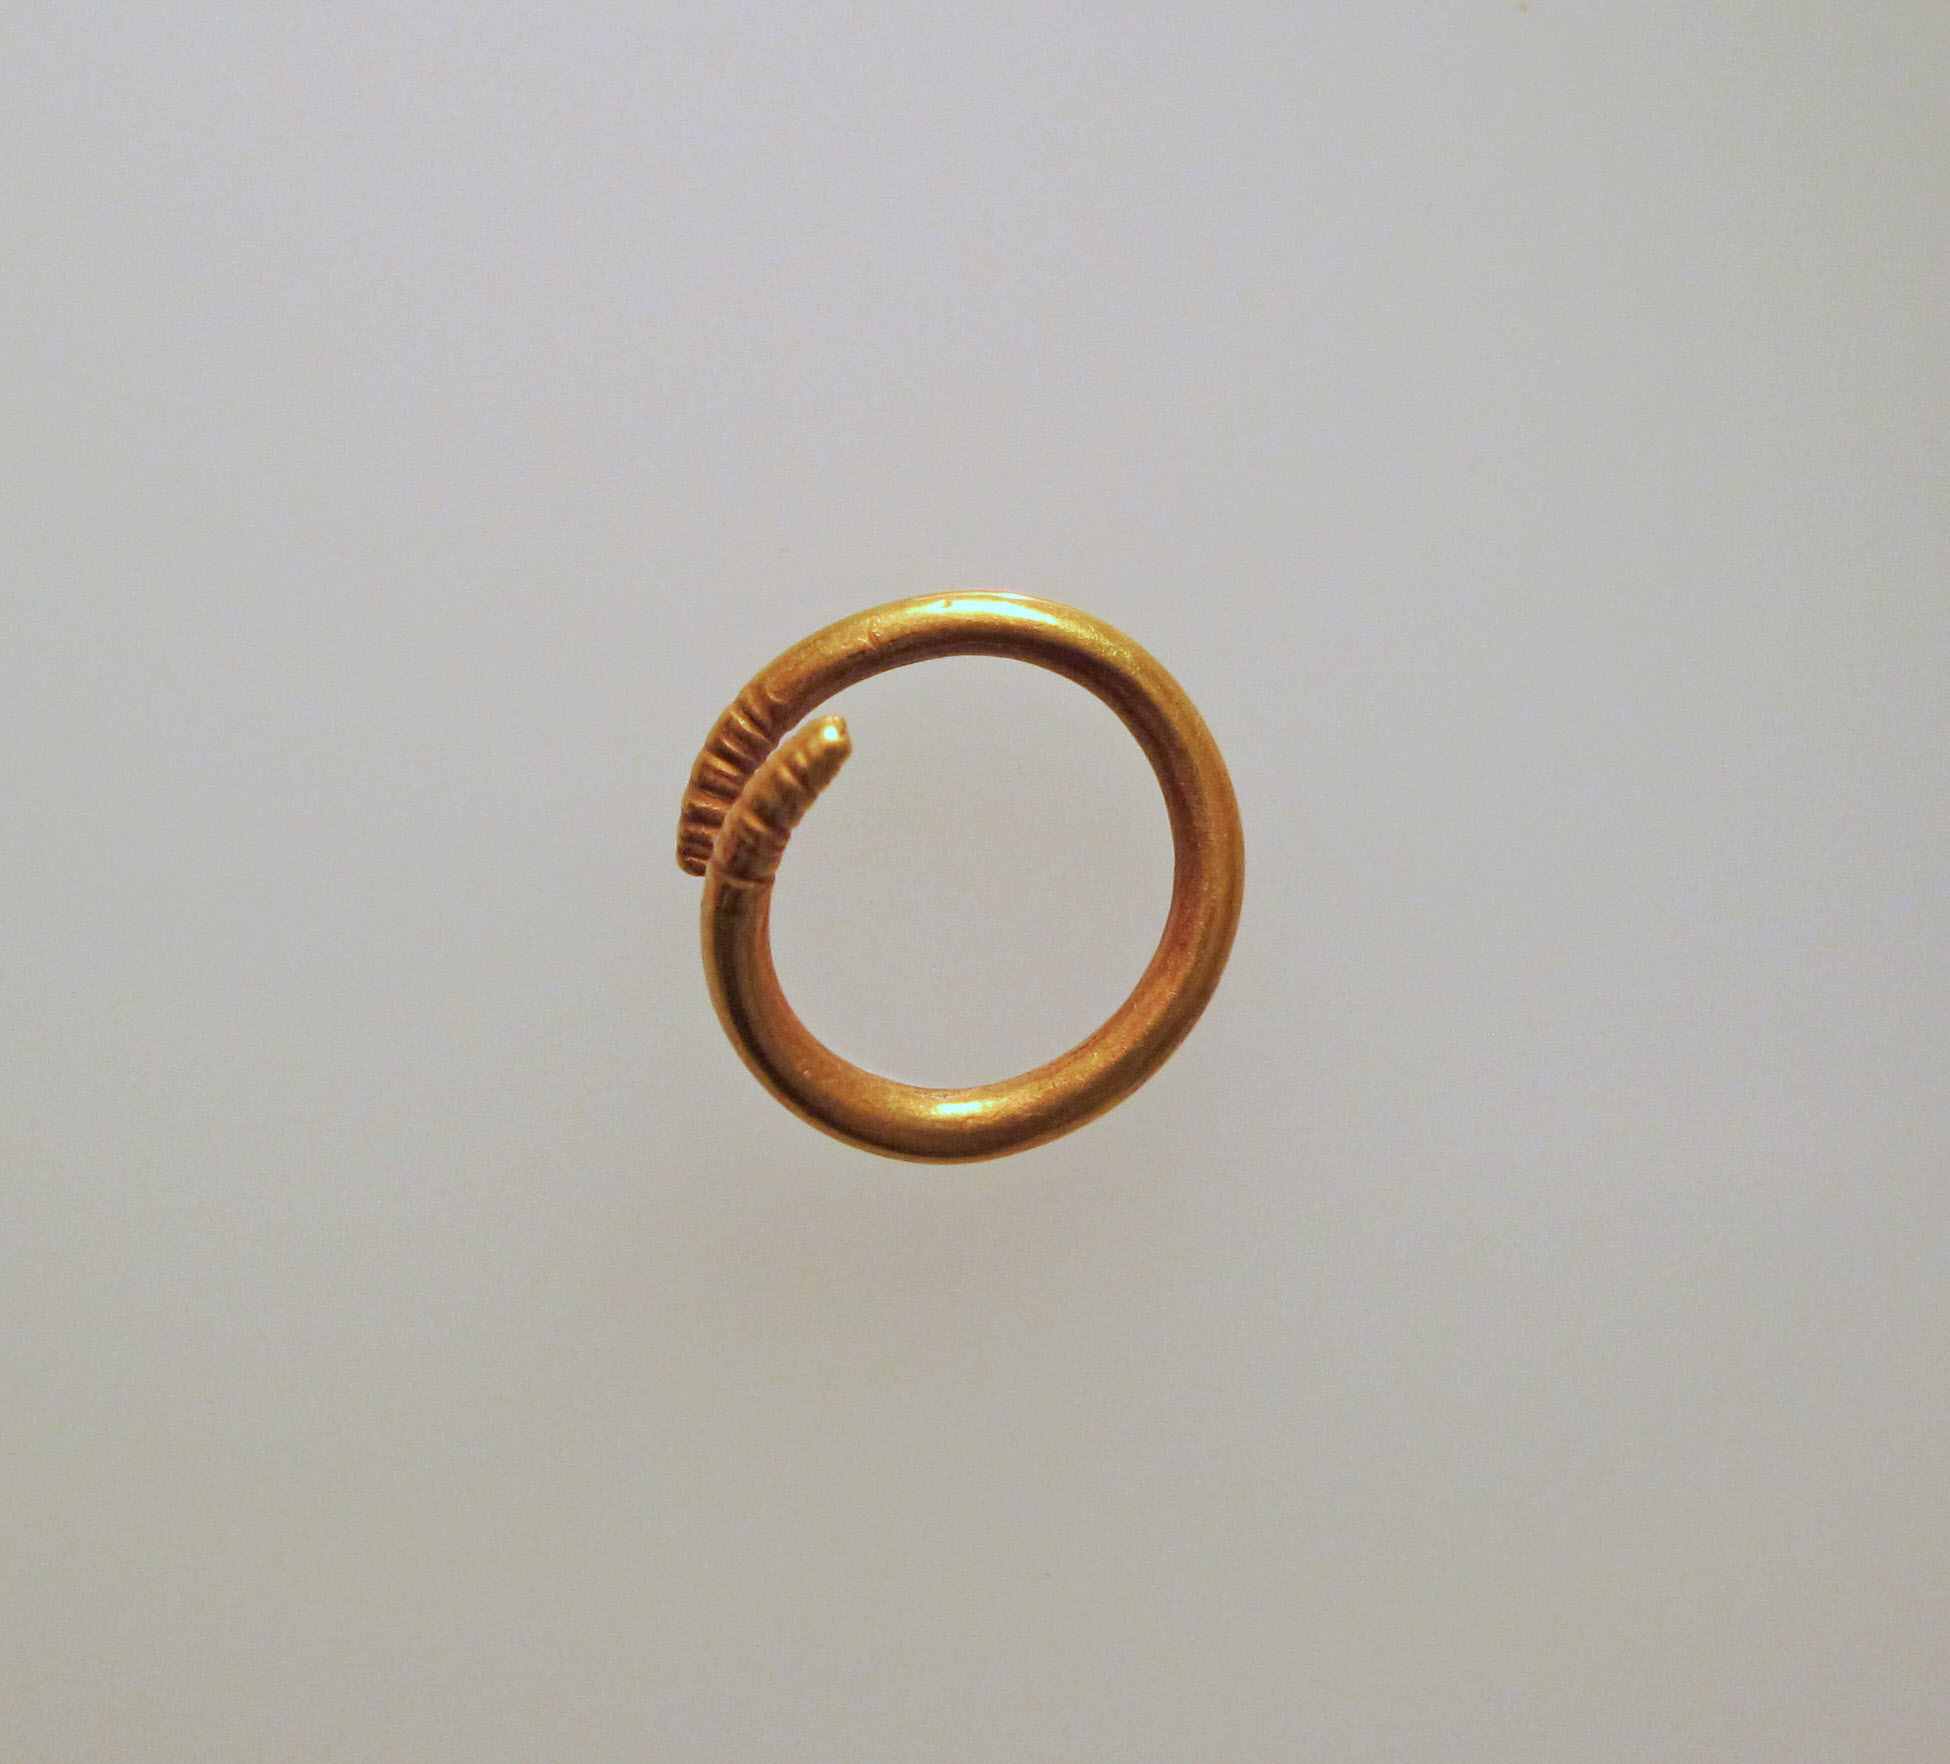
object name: spiral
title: Spirals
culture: cypriot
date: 3900 BCE-100 CE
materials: gold